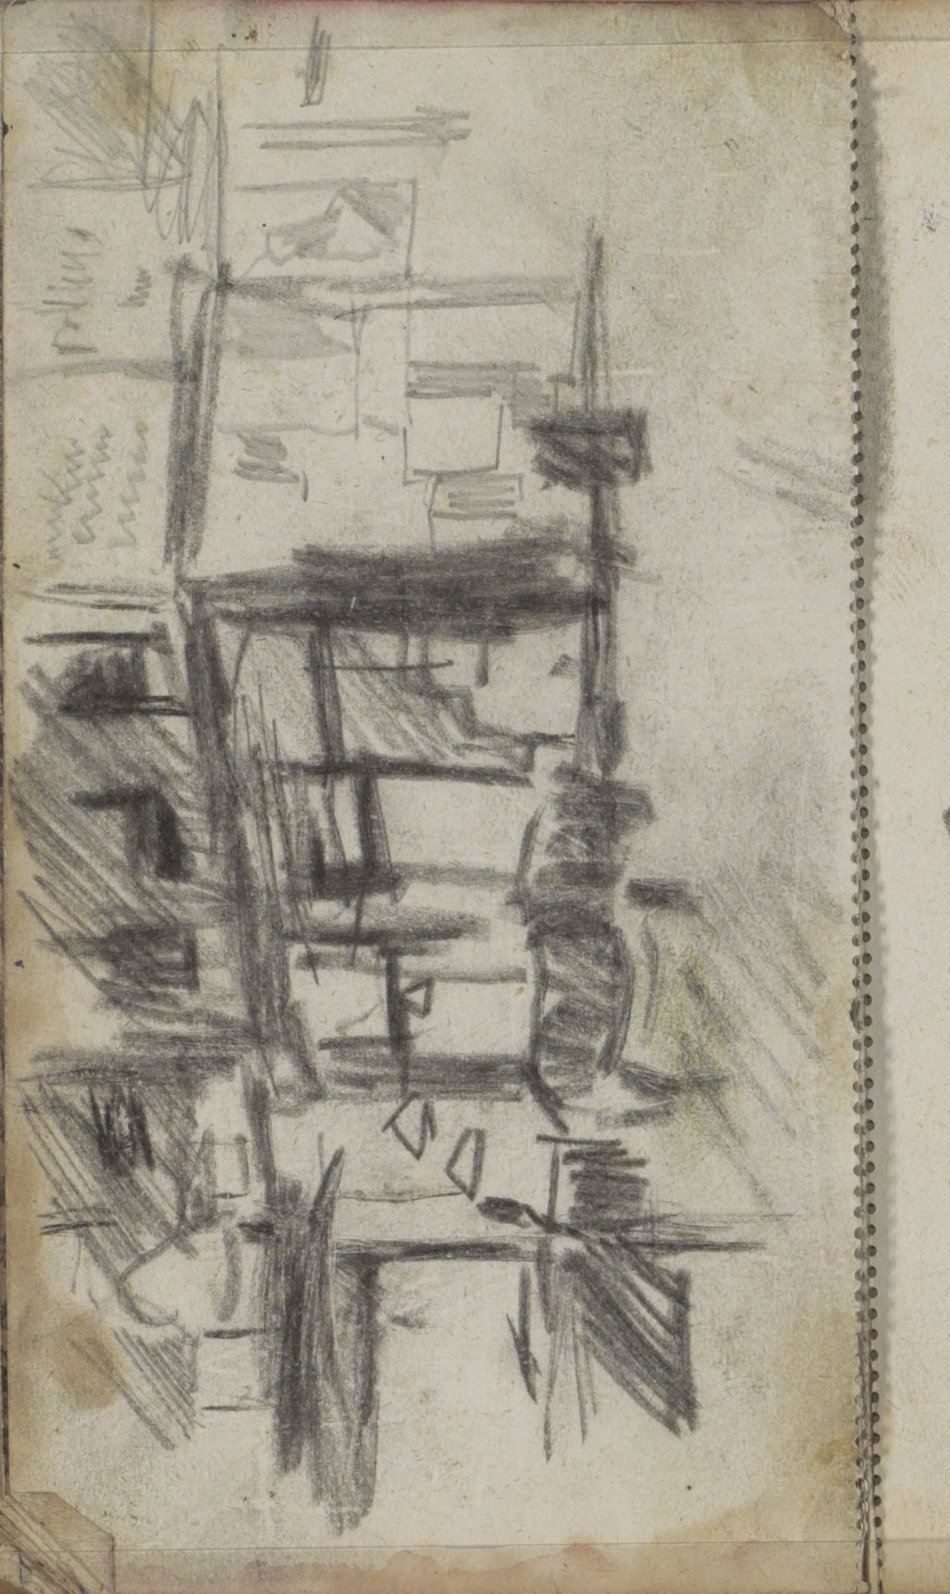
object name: sketchbook leaf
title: Gezicht op een hoekpand in Amsterdam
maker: george hendrik breitner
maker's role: draughtsman, painter, print maker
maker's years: 1857-1923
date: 1893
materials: chalk, paper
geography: amsterdam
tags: urban housing, amsterdam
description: Gezicht op een hoekpand in Amsterdam. Pagina 29 uit een schetsboek met 22 bladen vervaardigd te Amsterdam.